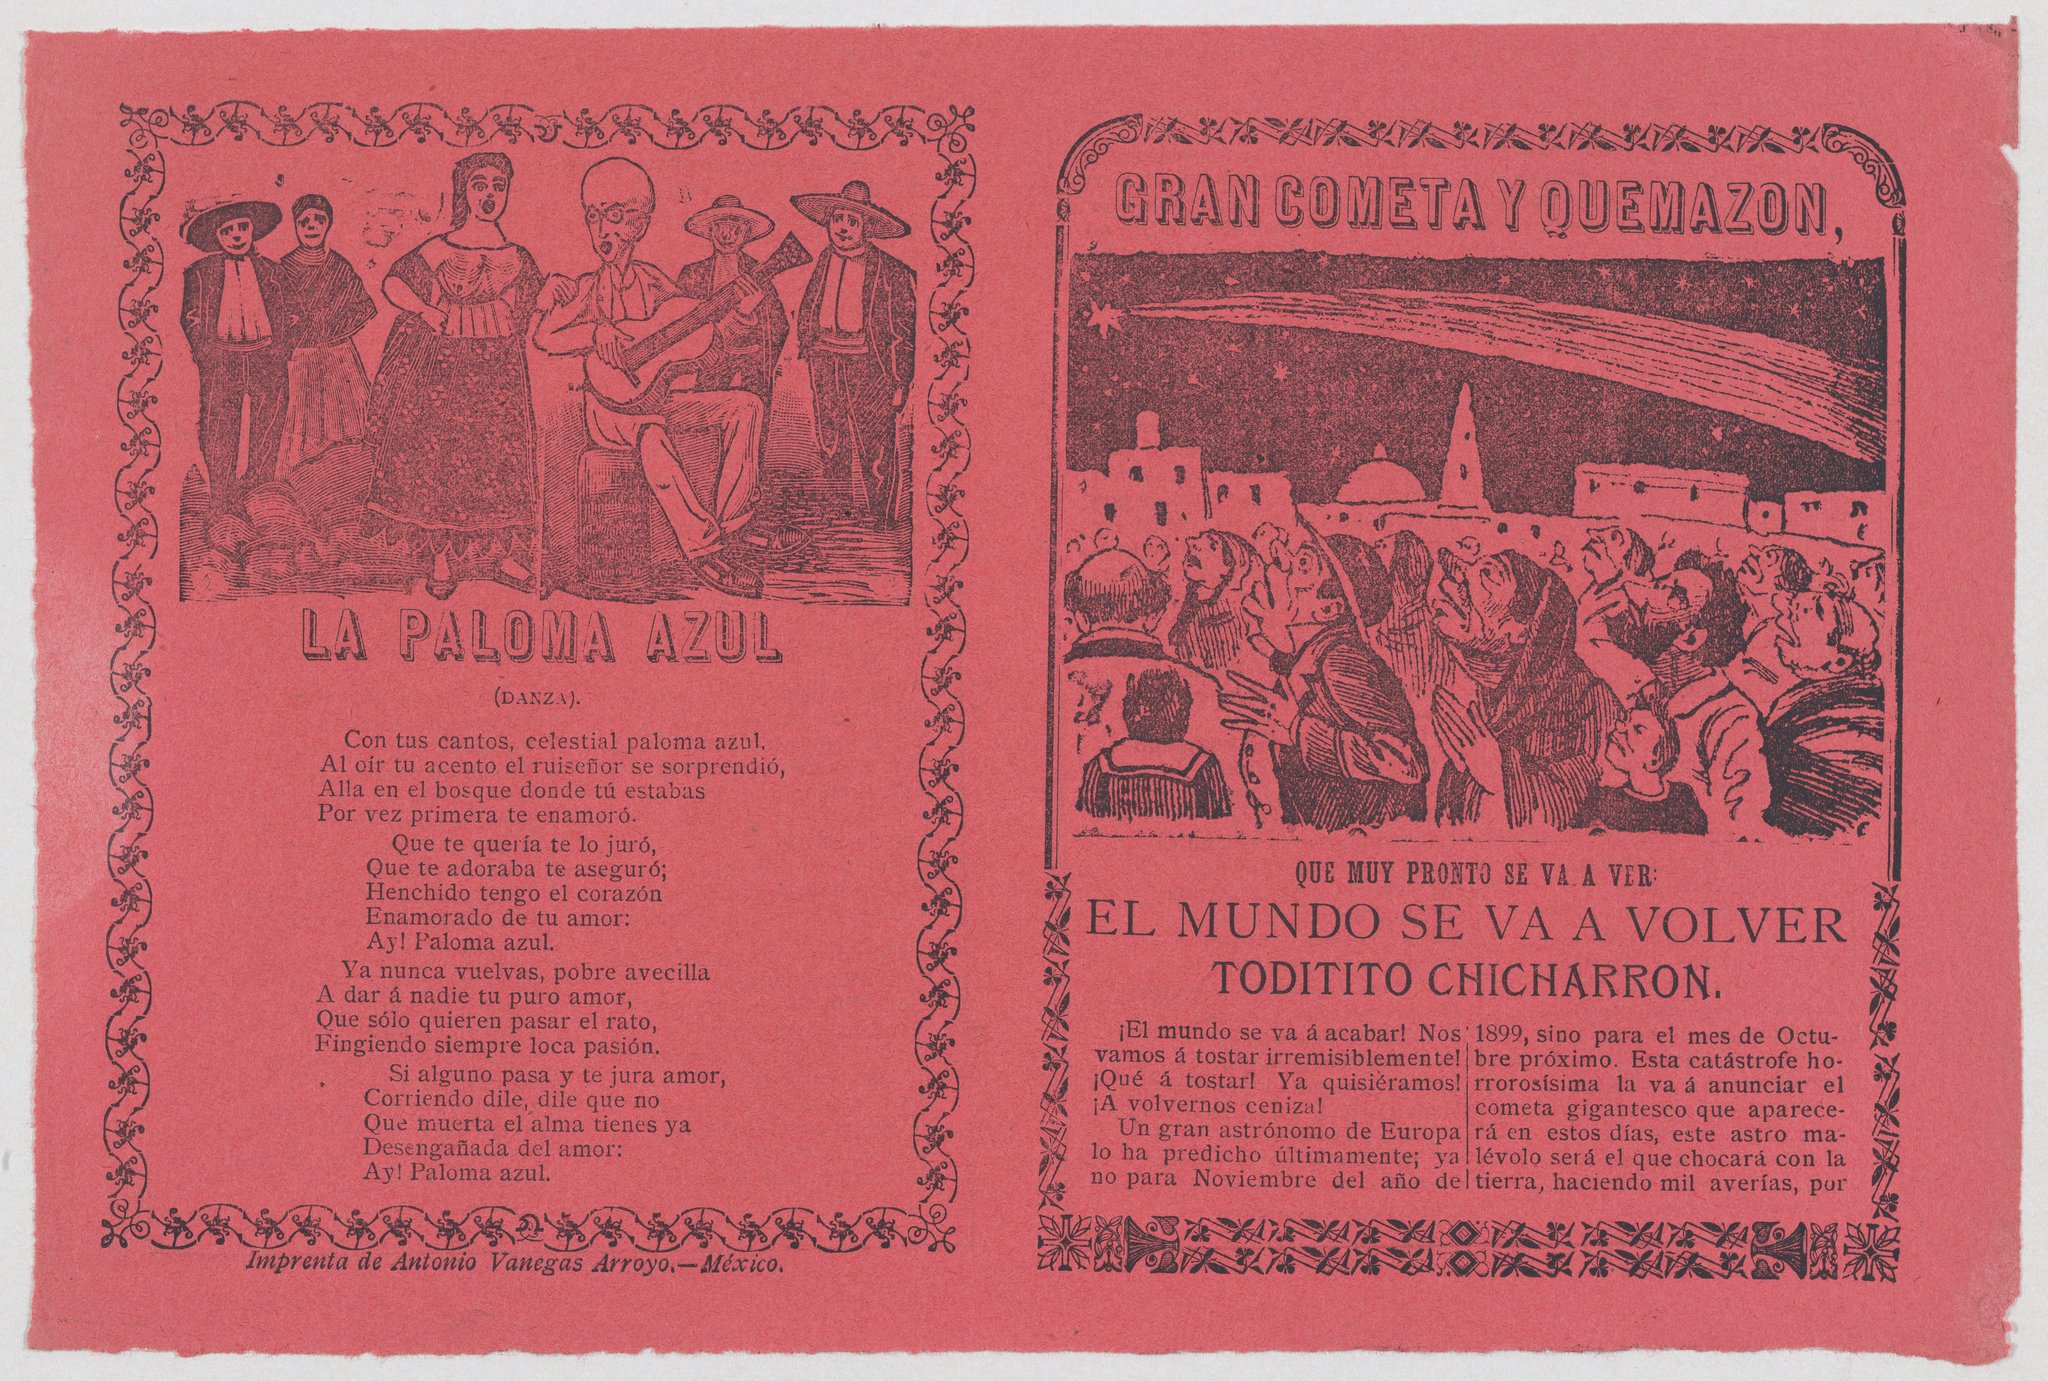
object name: print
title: Broadsheet relating to the apparition of a comet in Mexico in November 1899, and the words to a song 'La Paloma Azul'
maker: josé guadalupe posada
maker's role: artist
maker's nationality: mexican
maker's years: 1852-1913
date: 1899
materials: paper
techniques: letterpress, lithography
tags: men,women,guitars